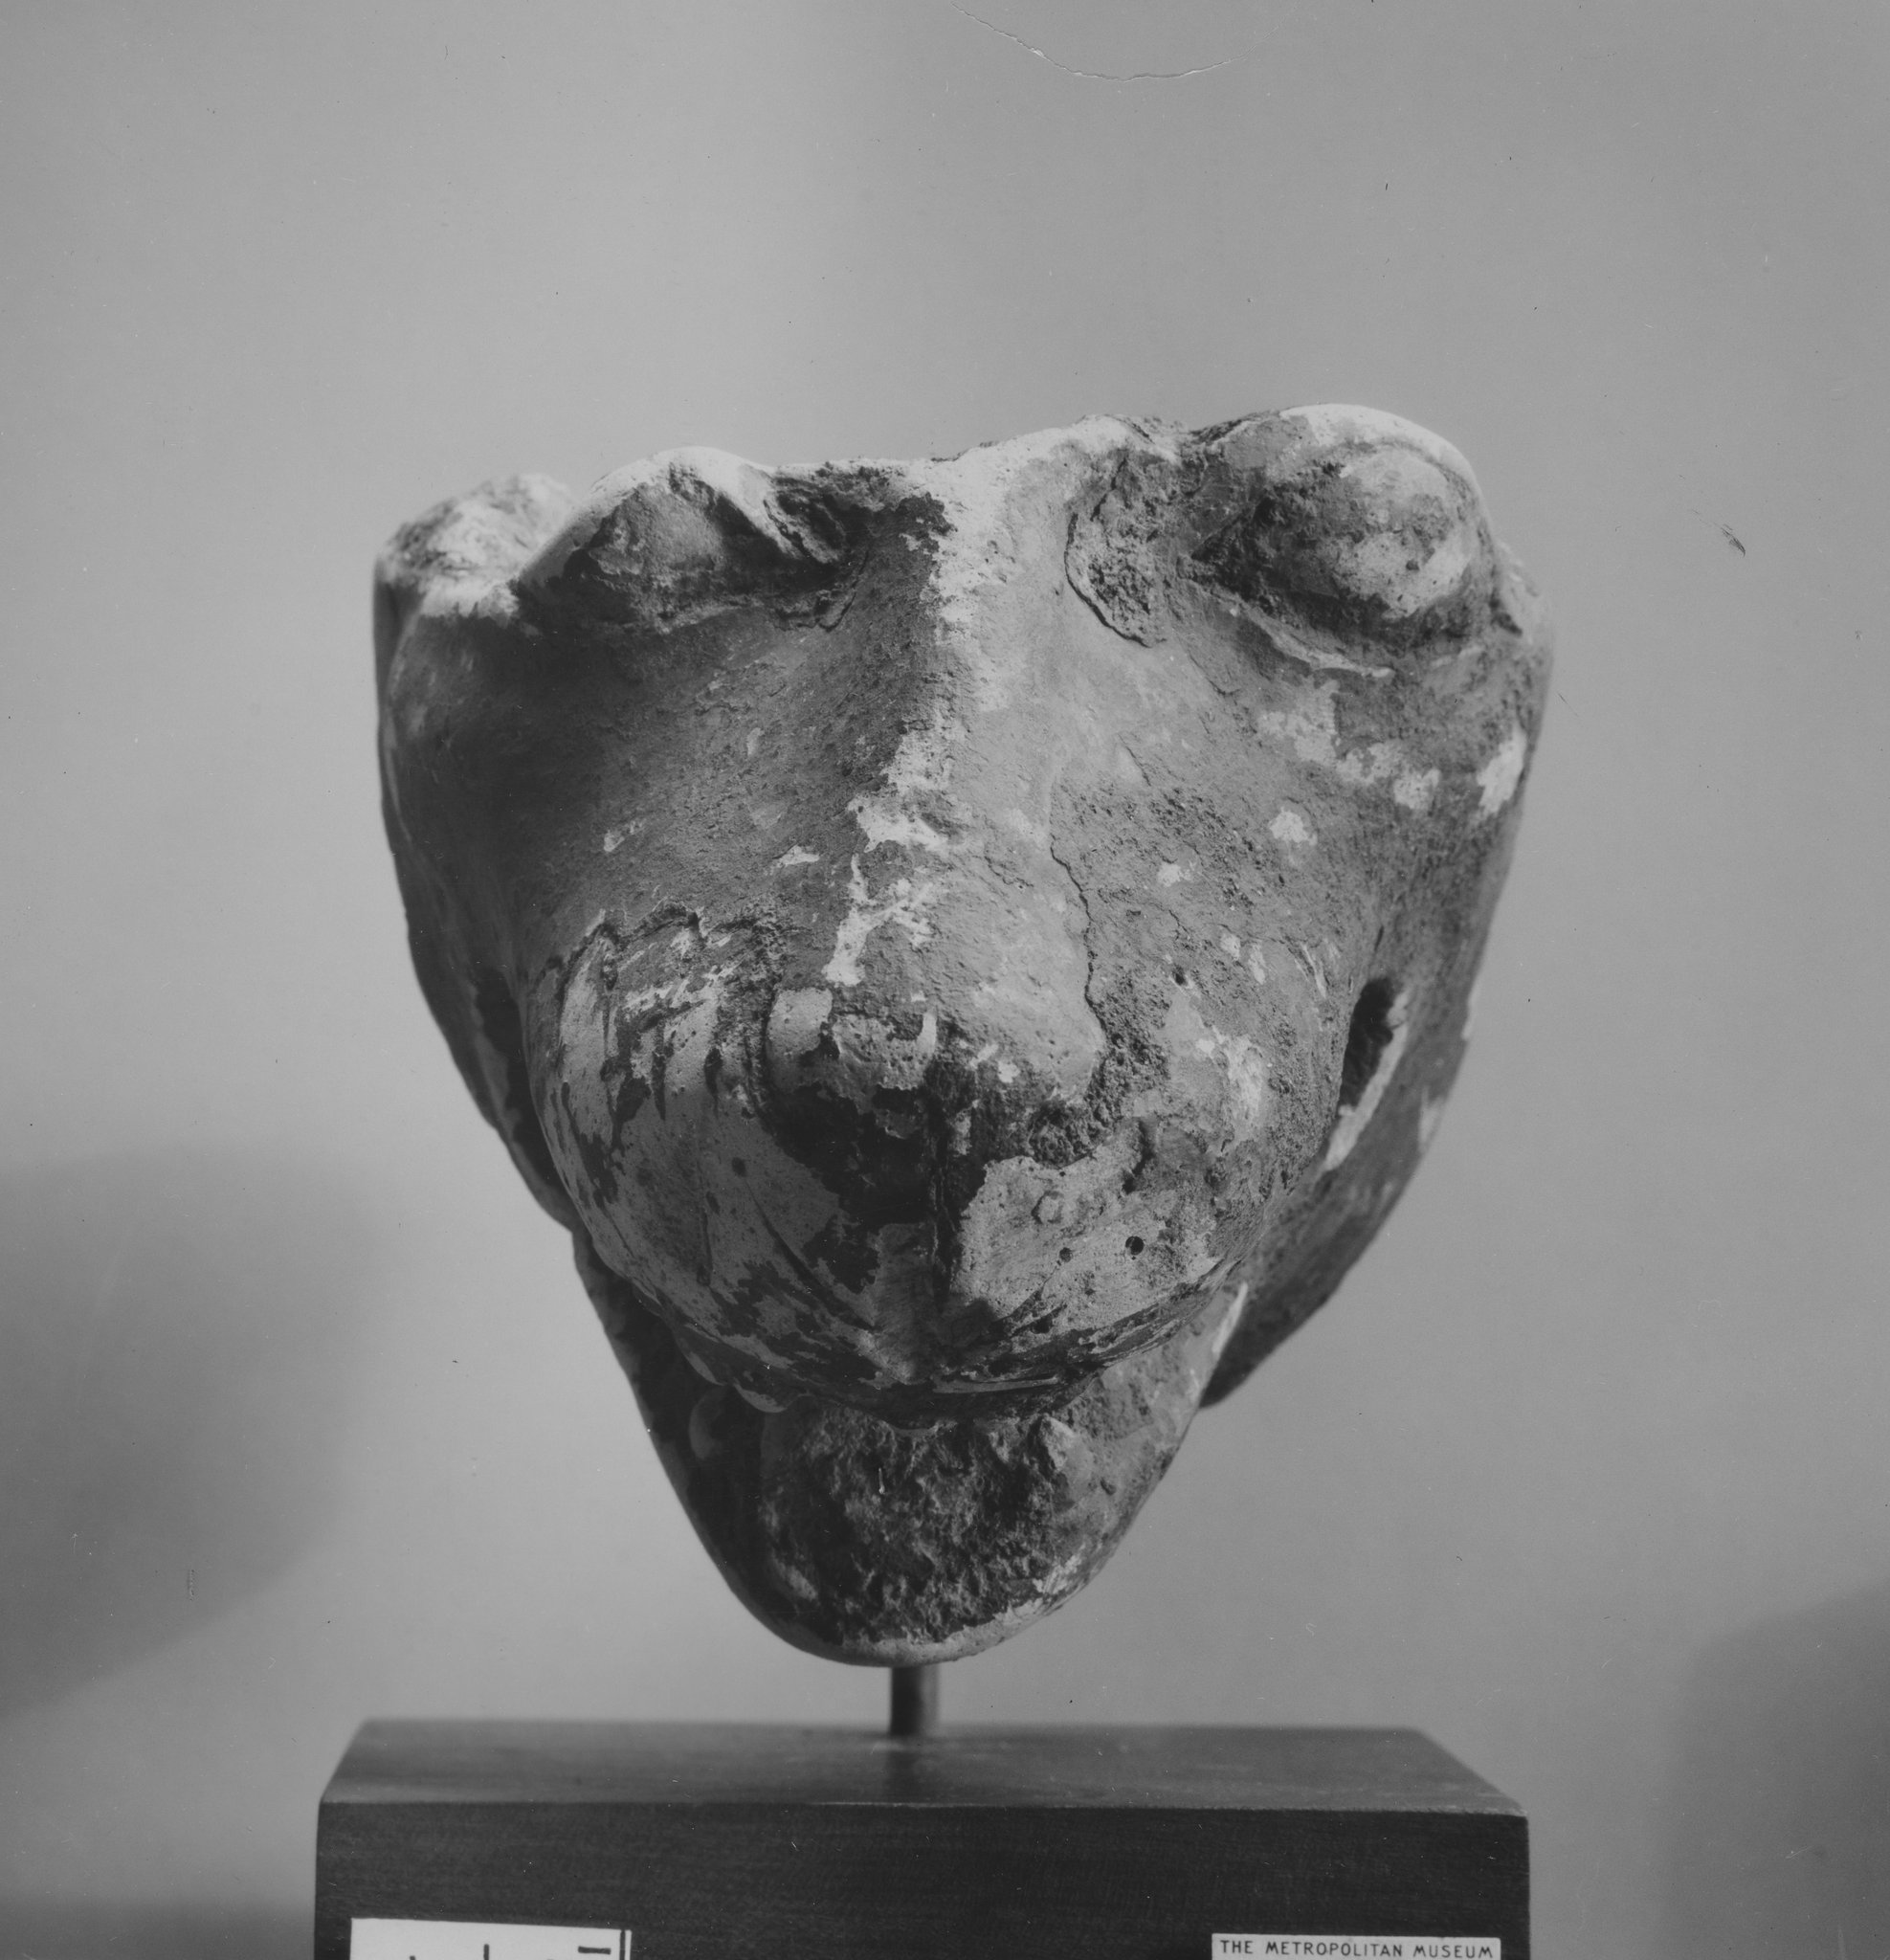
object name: head of a lion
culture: greek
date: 500-301 BCE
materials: terracotta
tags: lions